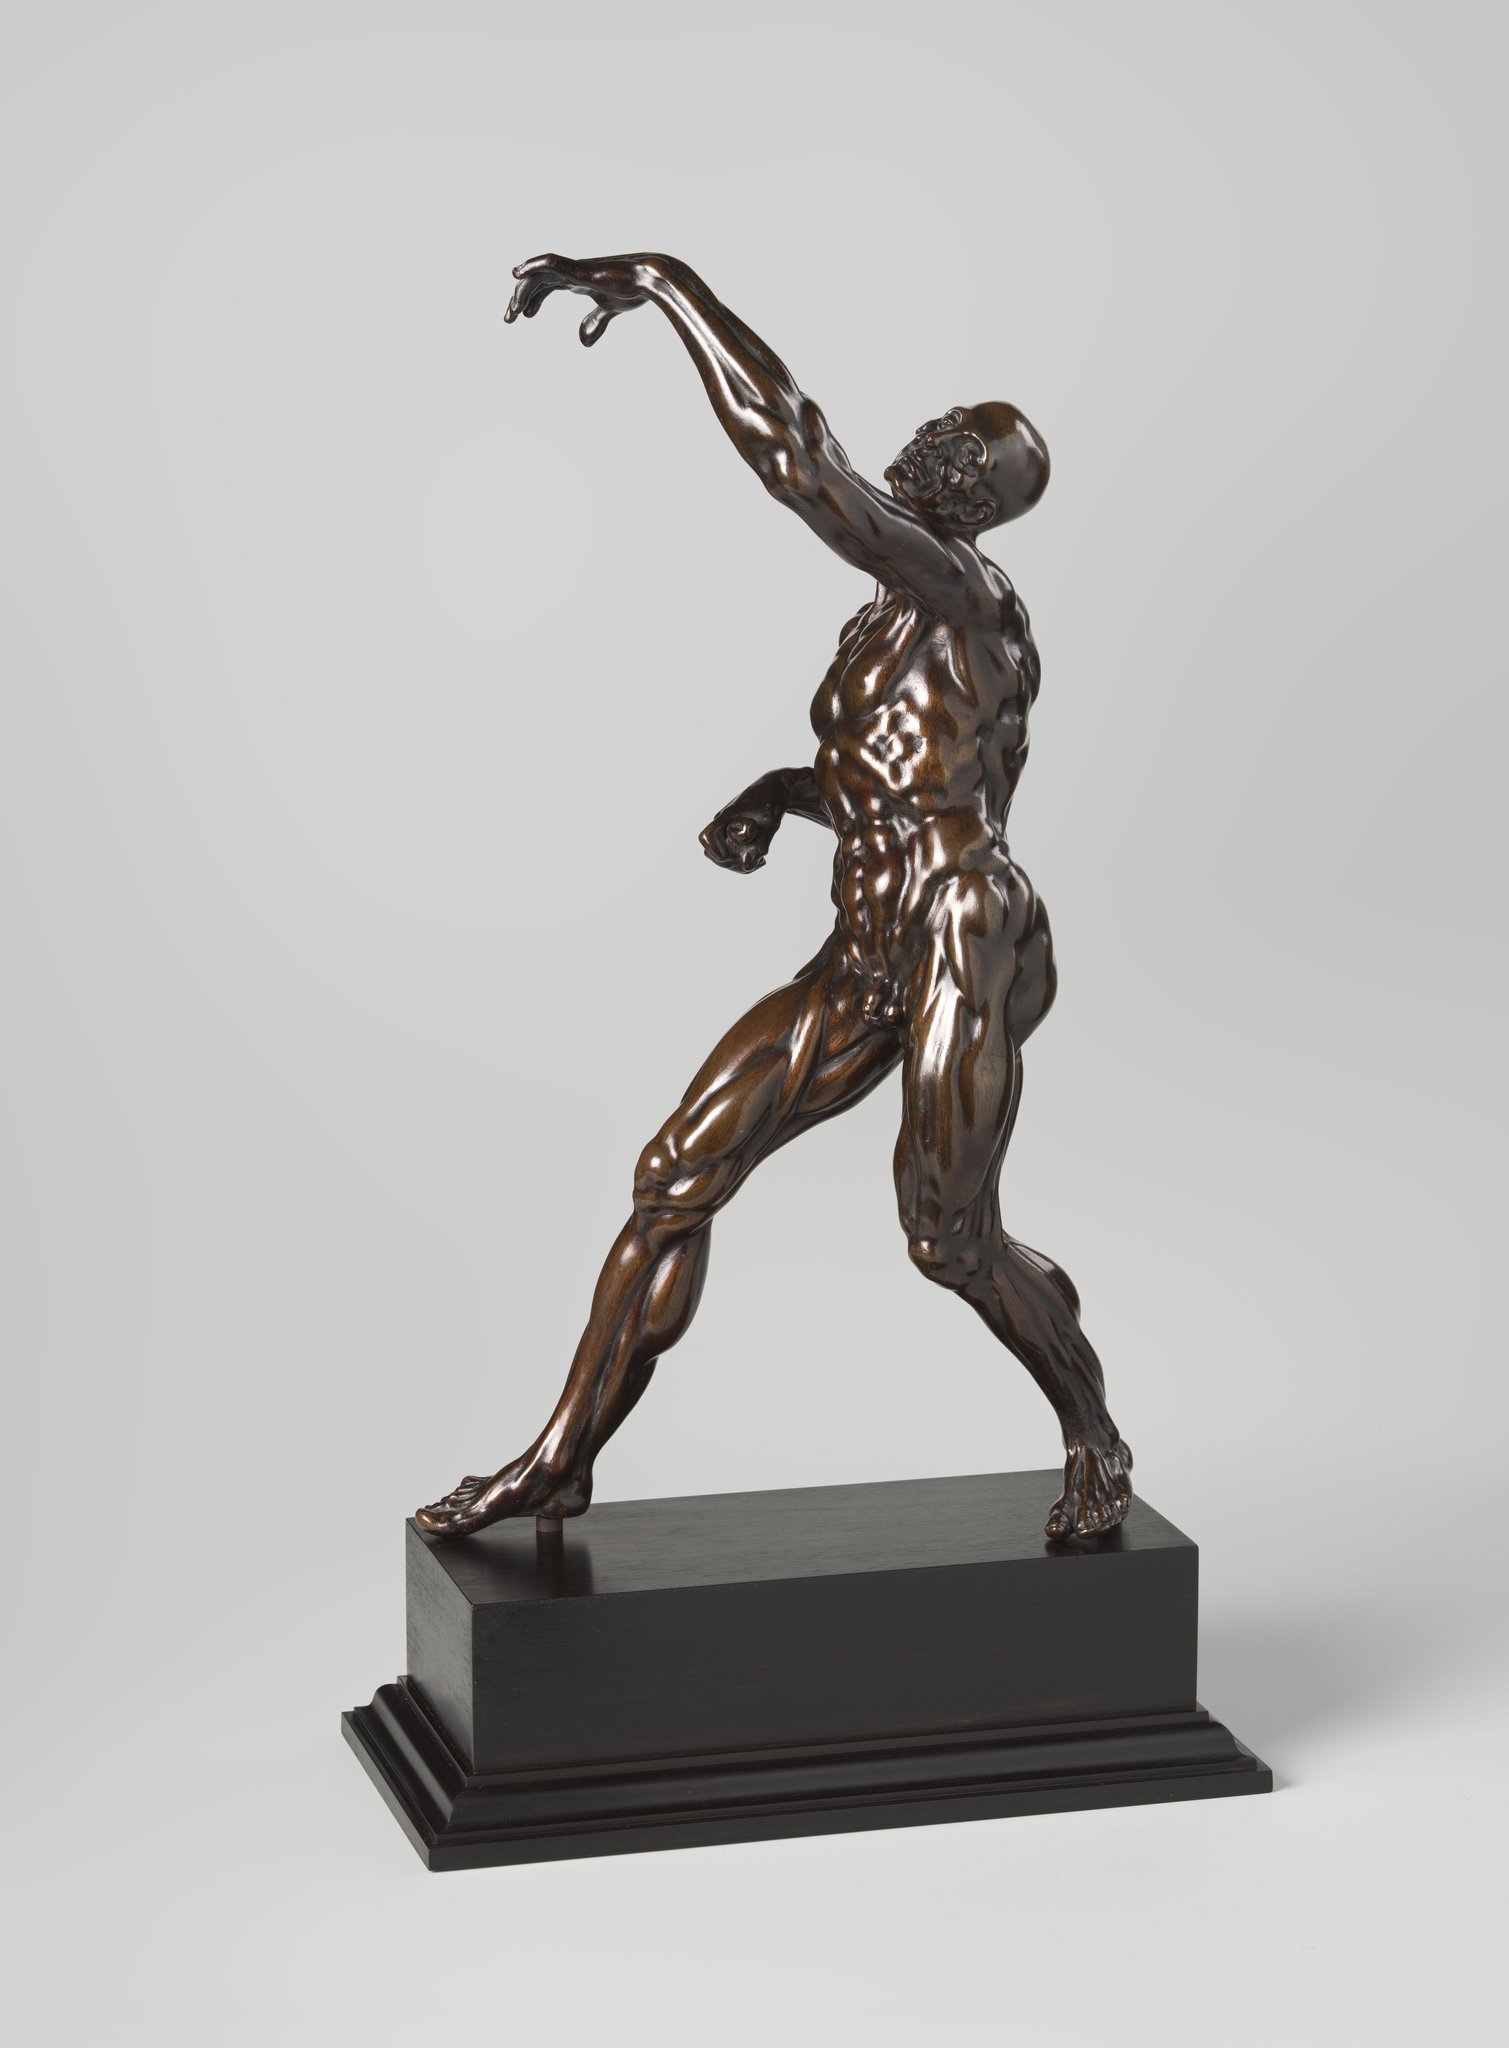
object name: figure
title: Ecorché (spierman)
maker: willem danielsz. van tetrode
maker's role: print maker, sculptor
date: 1560-1565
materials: bronze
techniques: casting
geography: florence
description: Beeld in brons van een anatomisch model - gevilde man - in een elegante loophouding, enigszins achterover hellend en de linkerarm omhooggehouden, terwijl de rechter op heuphoogte wordt gehouden. In zijn rechterhand houdt hij een restje van zijn afgestroopte huid.